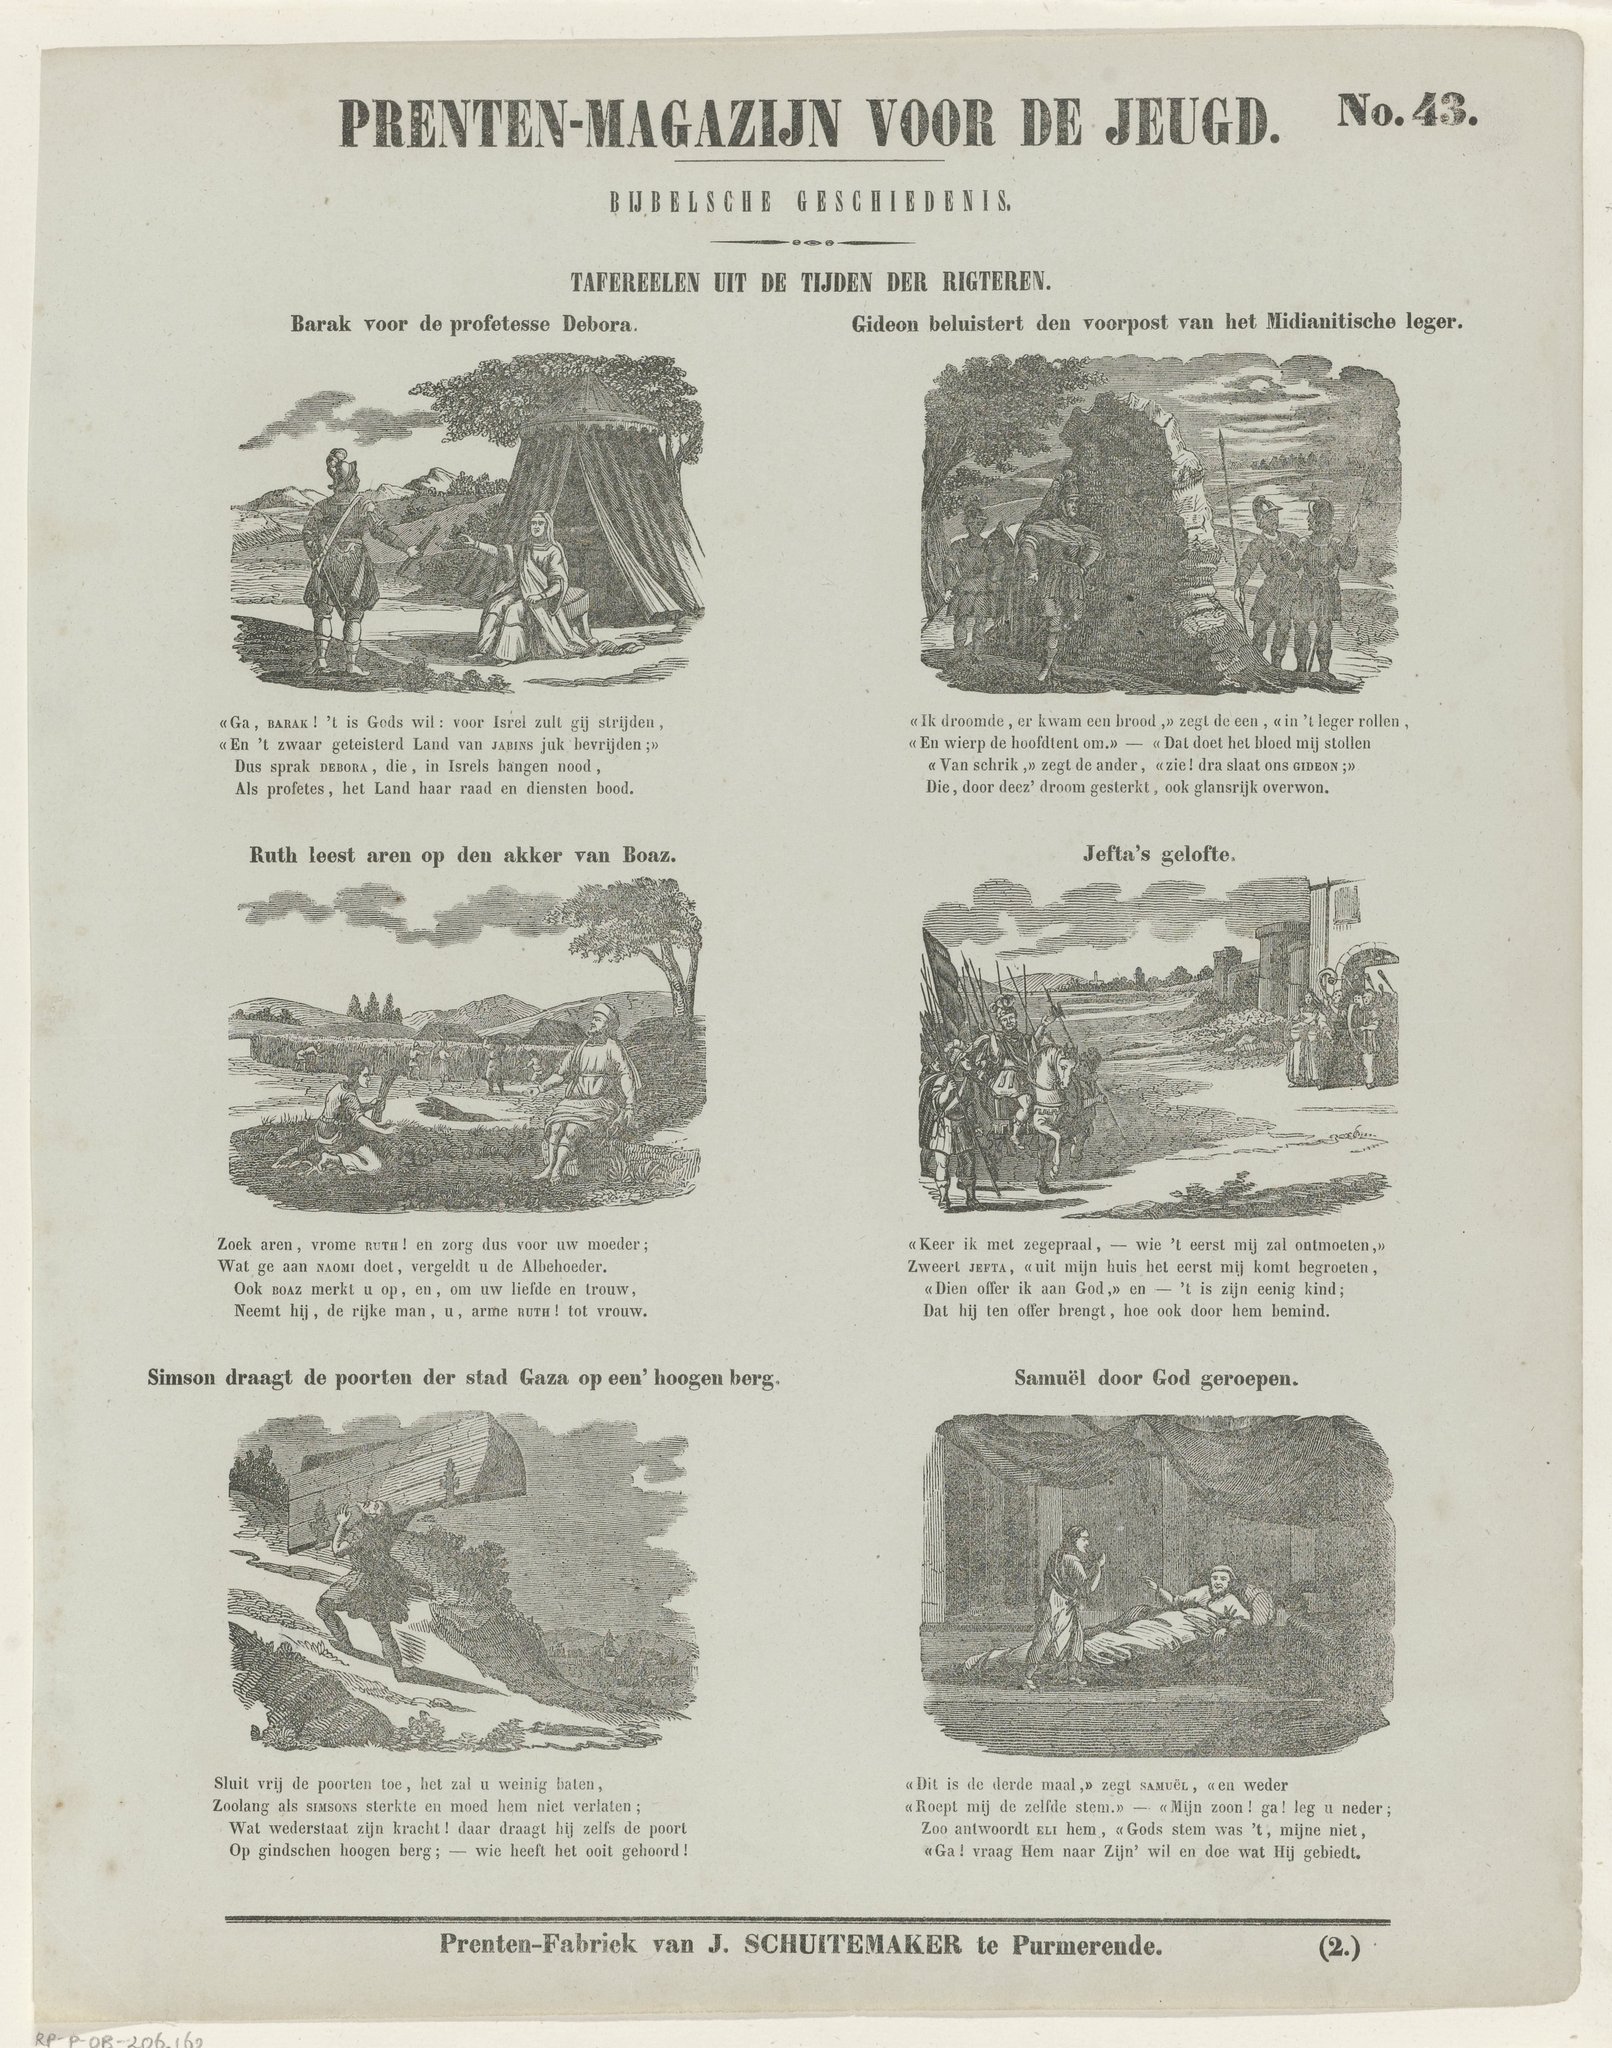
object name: print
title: Tafereelen uit de tijden der richteren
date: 1850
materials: paper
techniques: letterpress printing, engraving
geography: netherlands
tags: the time of the judges, old testament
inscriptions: collector's mark: Lugt 2760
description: Na voltooiing van de acht jaargangen van de reeks 'Prenten-magazijn voor de jeugd' in 1850 heeft Jan Schuitemaker al deze prenten heruitgegeven en omgenummerd als nr. 1 t/m 192. De oorspronkelijke jaargang wordt telkens nog vermeld rechtsonder op de prent. Binnen de jaargangen zijn prenten van hetzelfde thema in clusters van vier achter elkaar gezet.